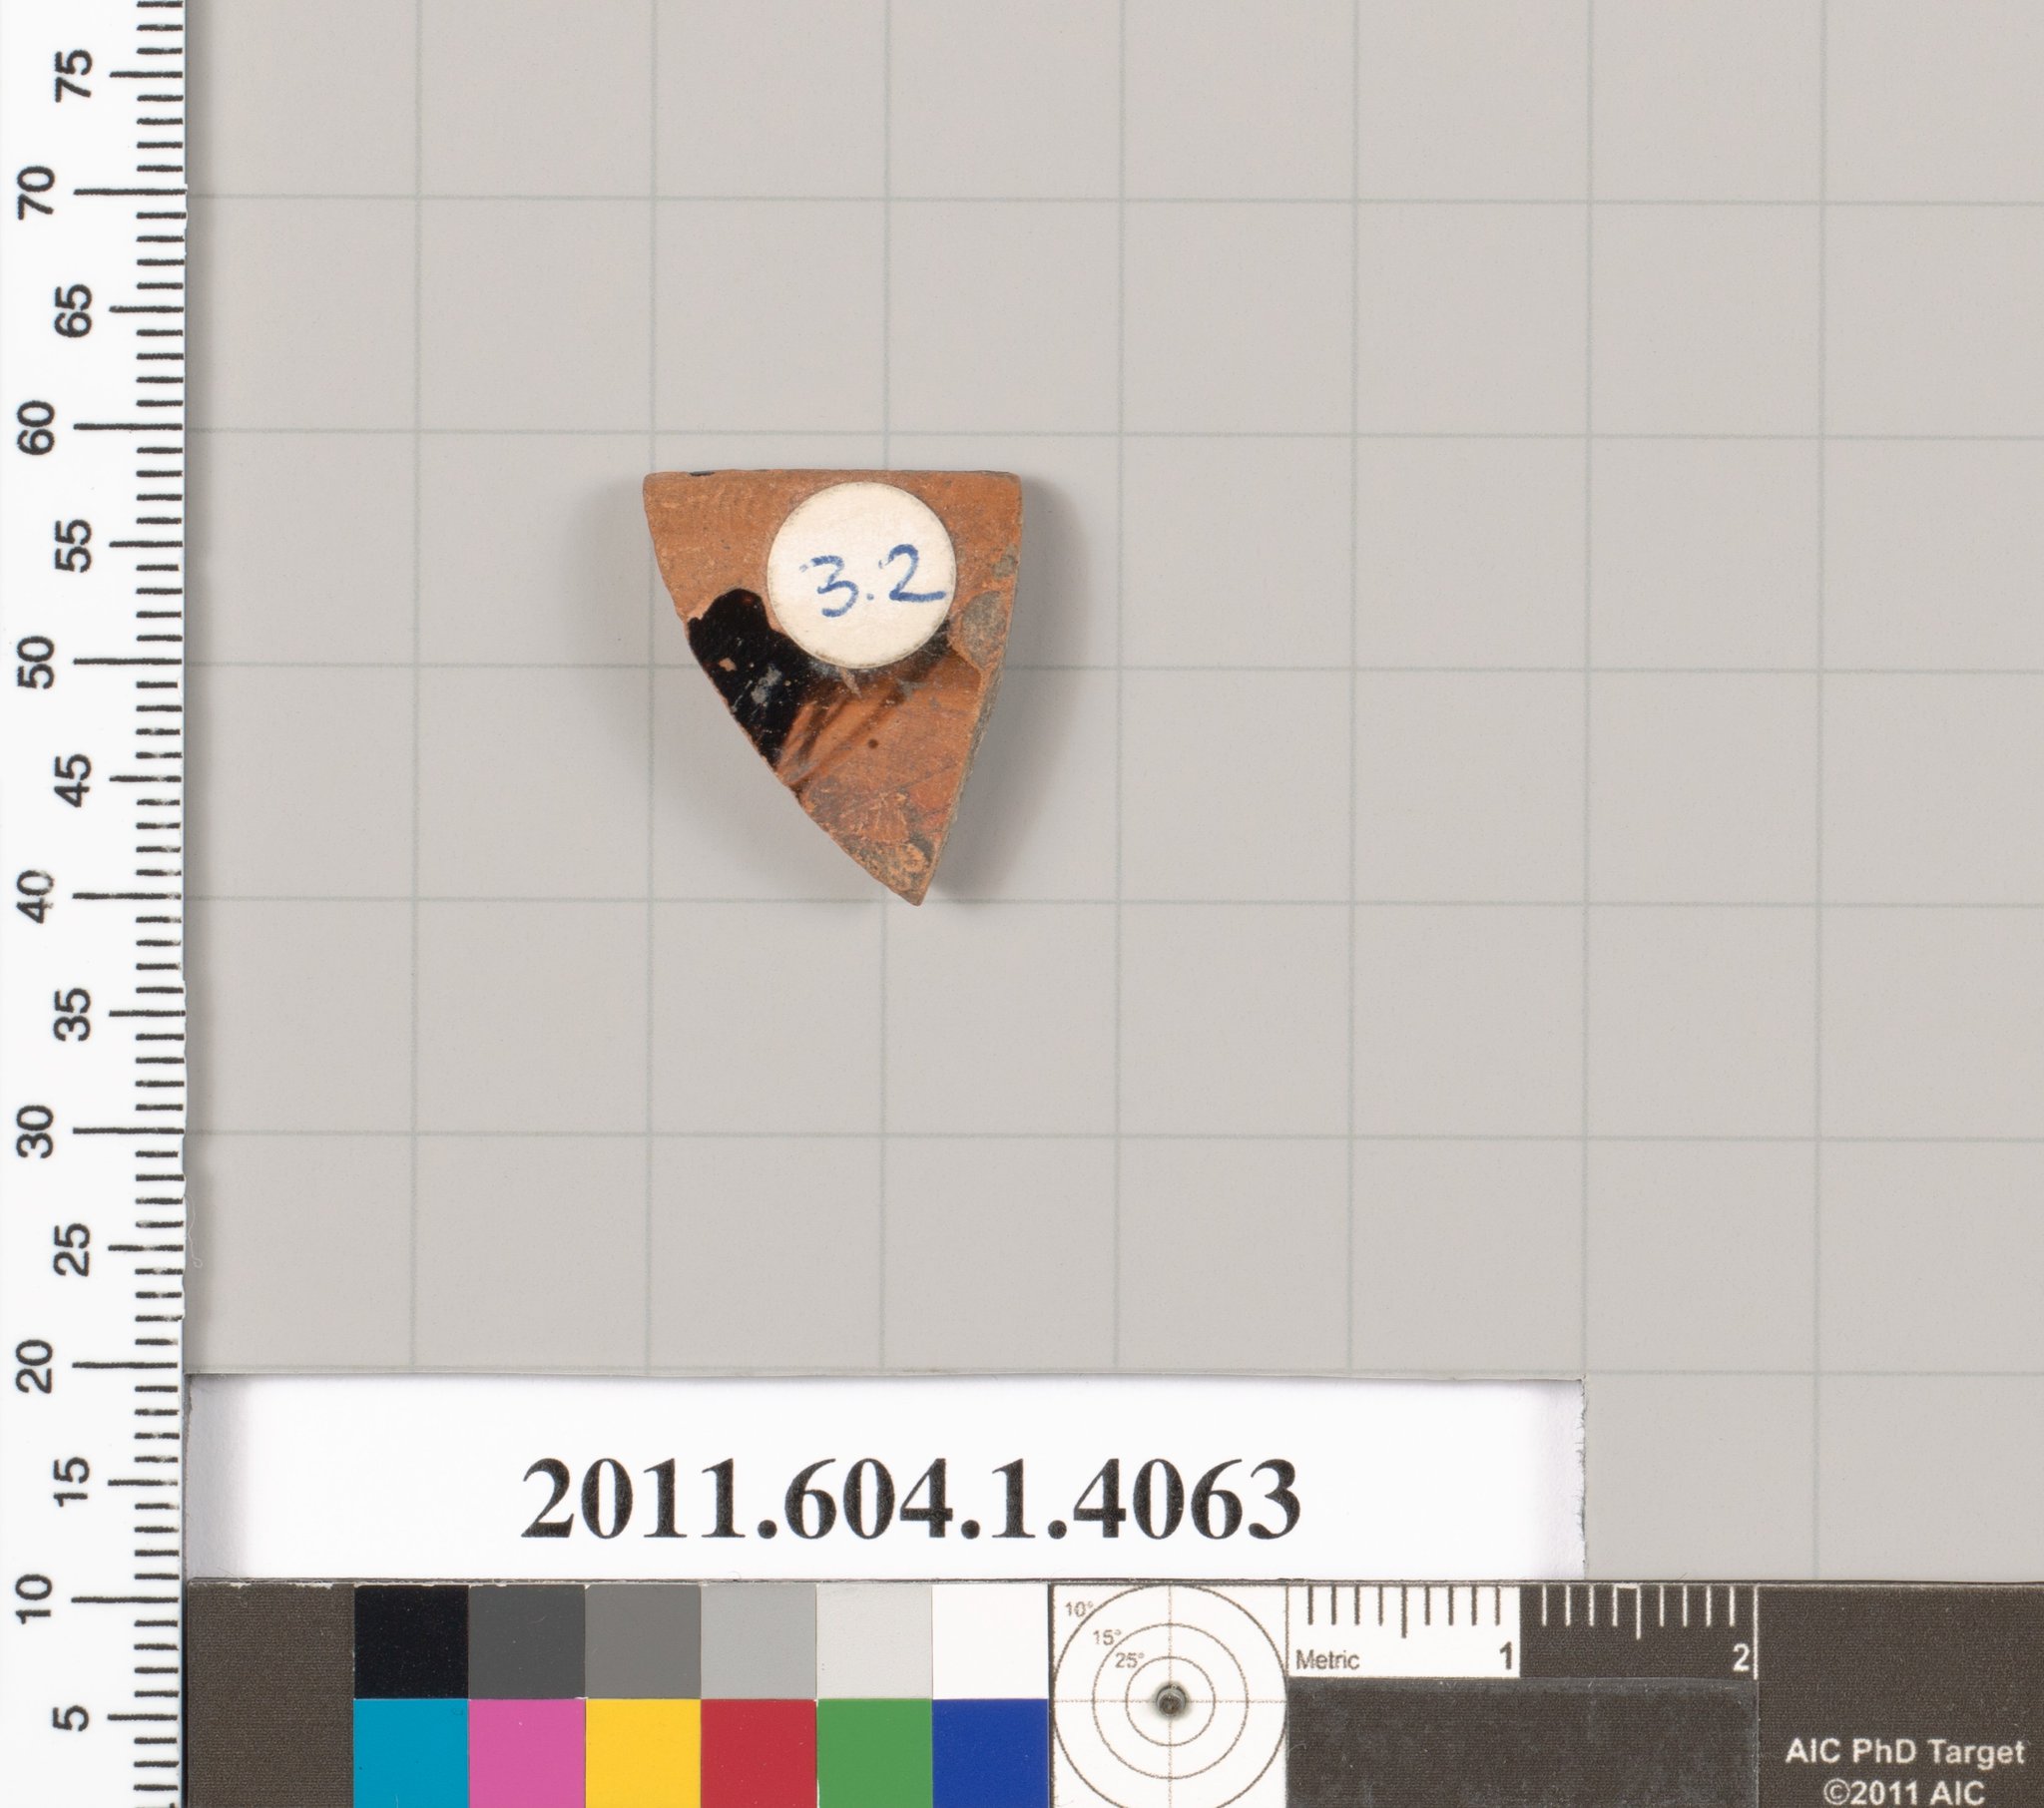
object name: kylix fragment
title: Terracotta fragment of a kylix (drinking cup)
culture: greek, attic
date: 500-451 BCE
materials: terracotta